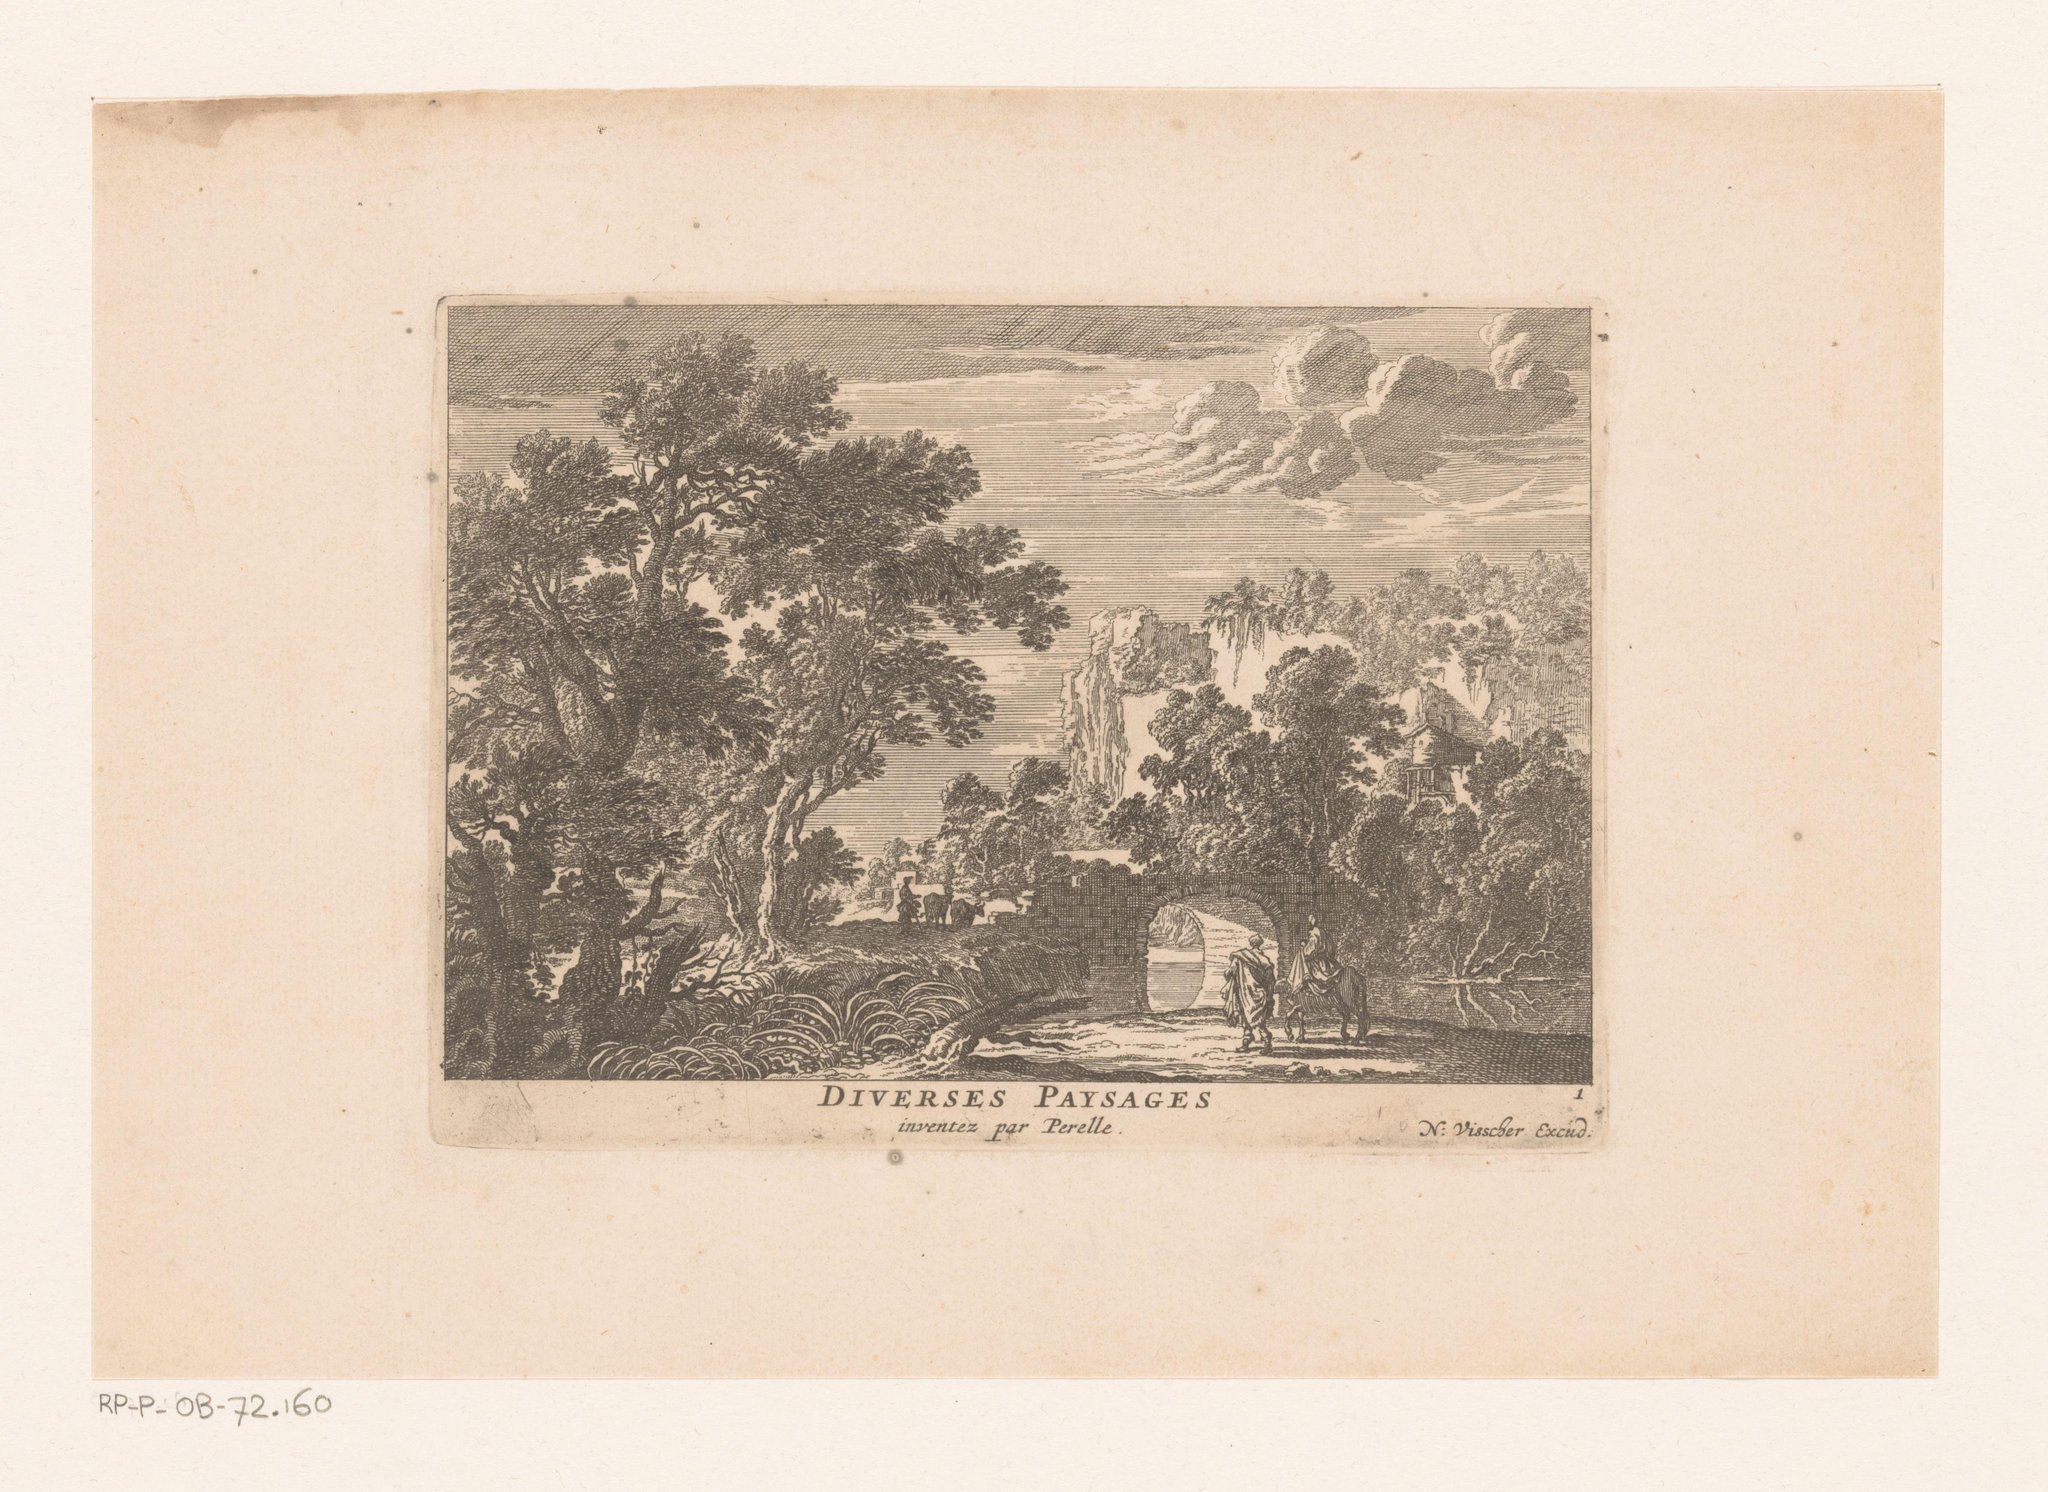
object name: print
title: Diverses Paysages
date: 1628-1679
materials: paper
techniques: etching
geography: amsterdam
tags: landscape with bridge, viaduct or aqueduct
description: Prenten met het signatuur 'Perelle' kunnen zowel door vader Gabriel als door zonen Nicolas en Adam gemaakt zijn.